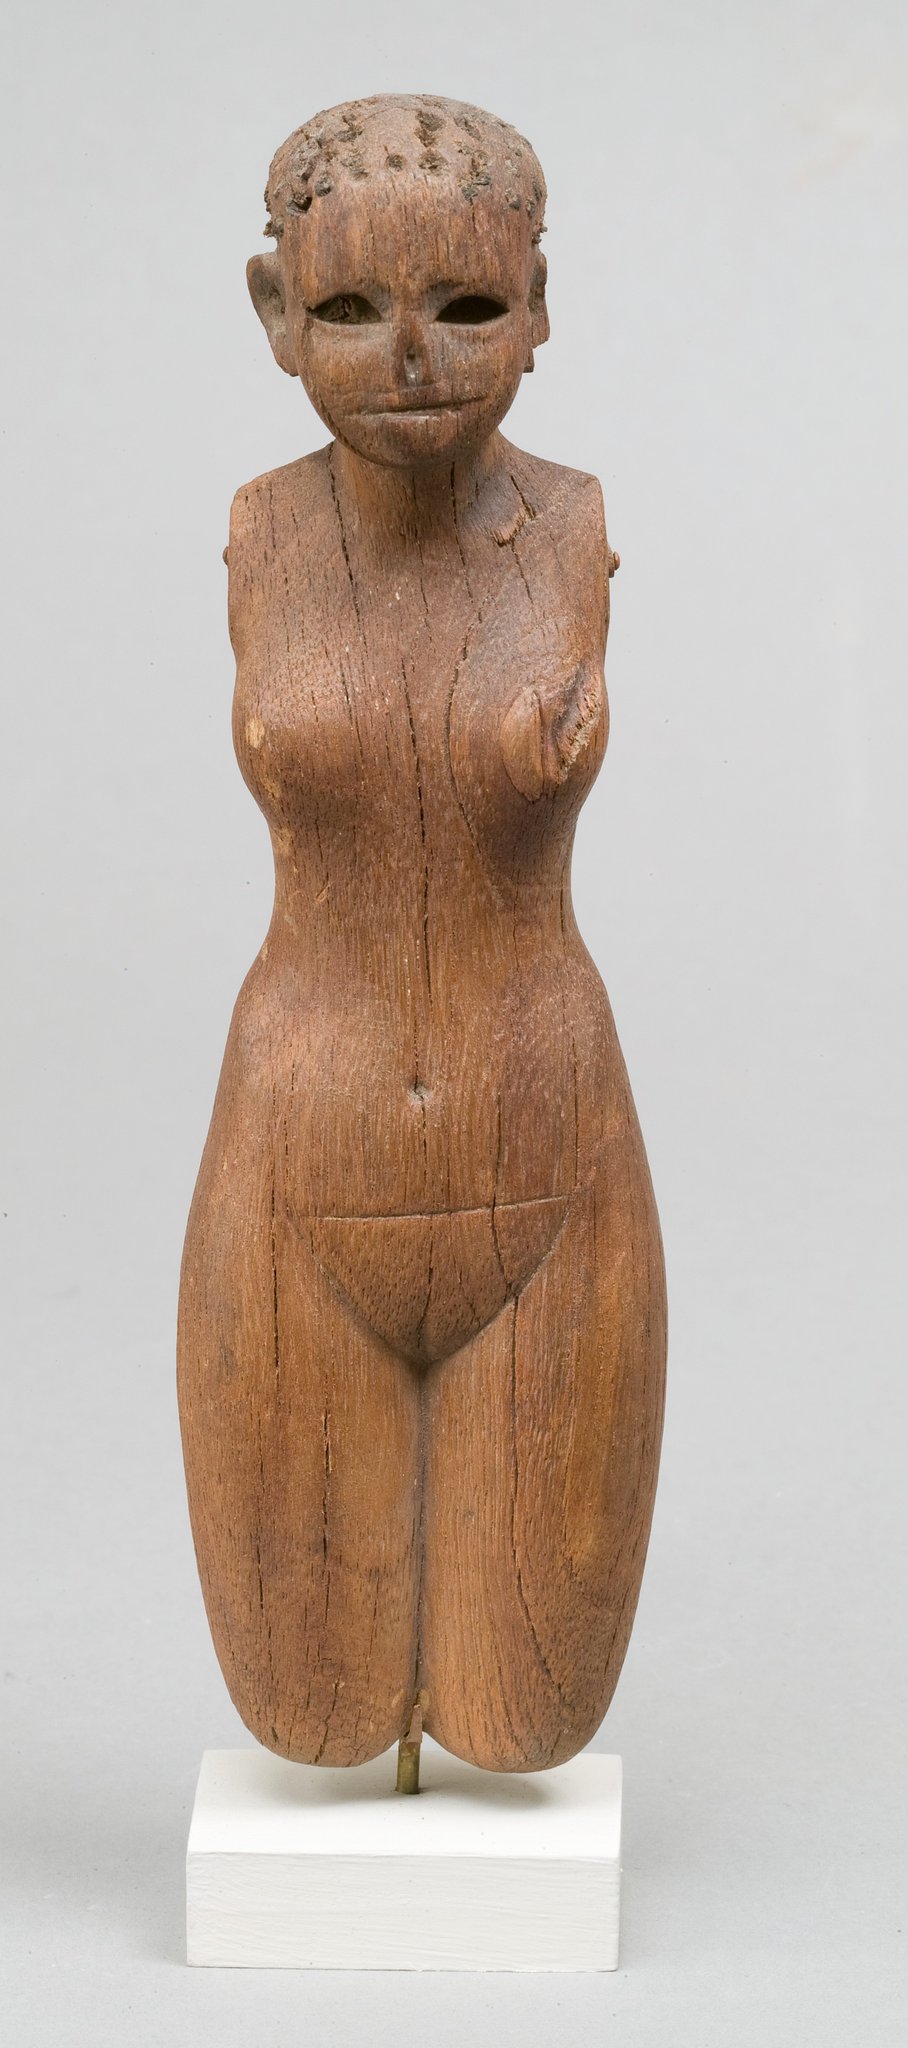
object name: statuette of a woman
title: Statuette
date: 1850-1640 BCE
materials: wood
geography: egypt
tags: women